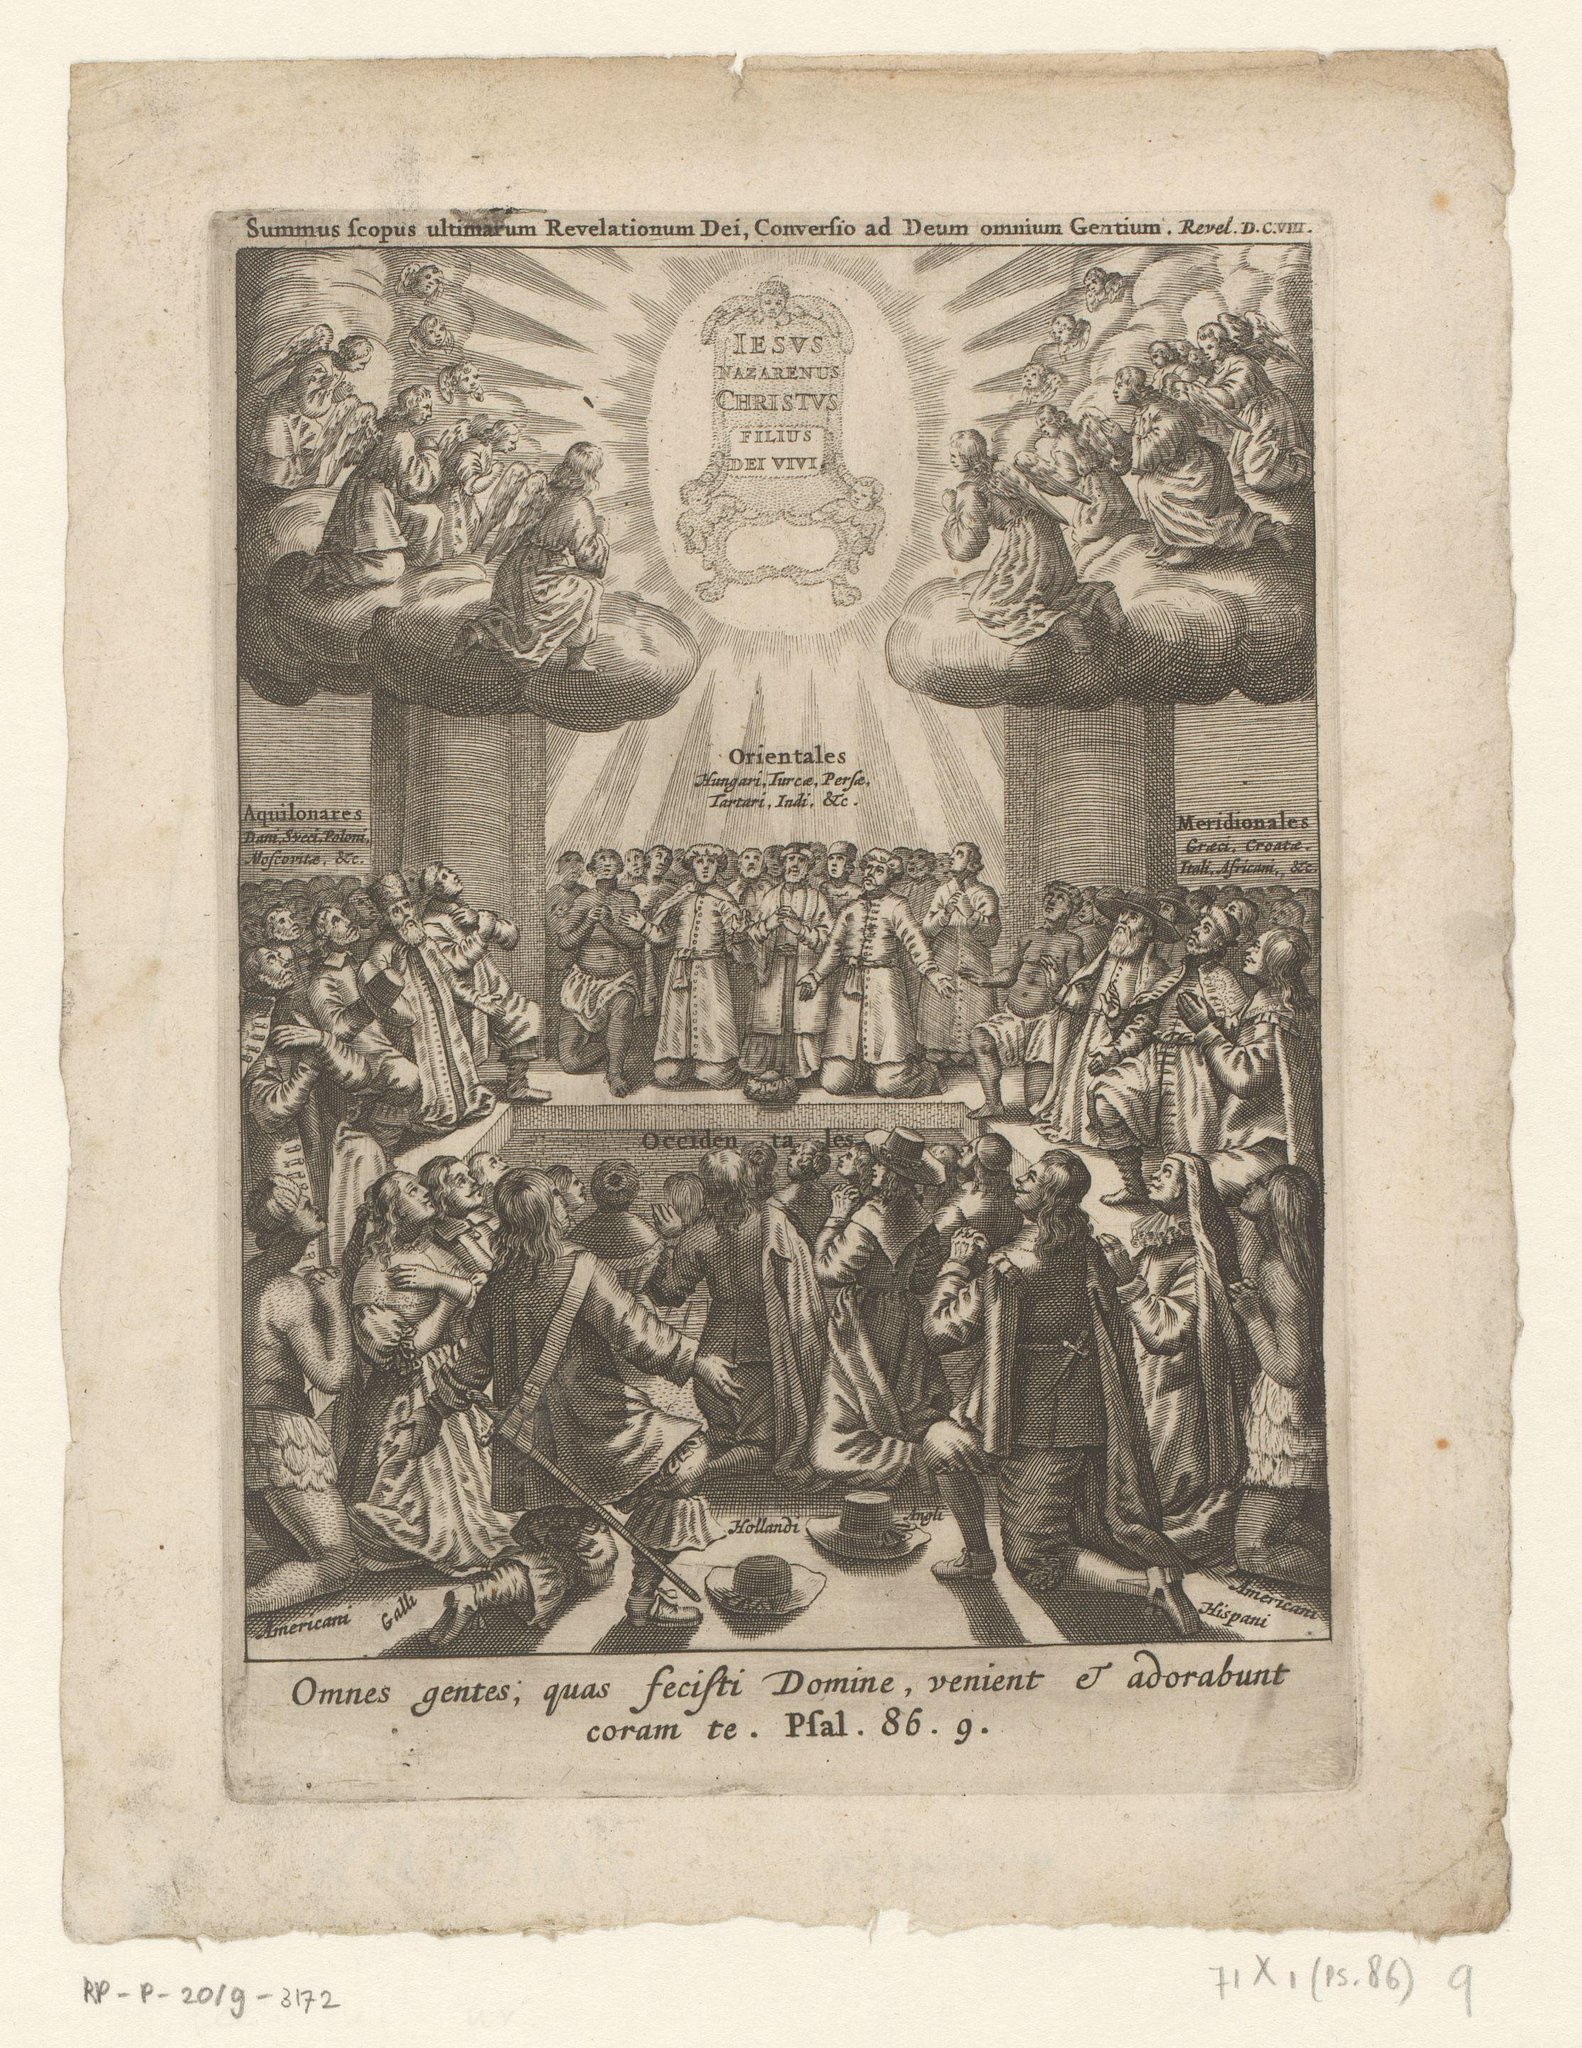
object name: print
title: Verschillende volkeren aanbidden Christus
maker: Anonymous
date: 1600-1699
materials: paper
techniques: engraving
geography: netherlands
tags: (public) prayer, the book of psalms (with book chapter:verse)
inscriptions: collector's mark: Lugt 2228